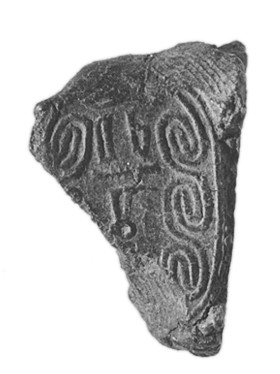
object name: sealing fragment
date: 2030-1640 BCE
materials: clay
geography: egypt